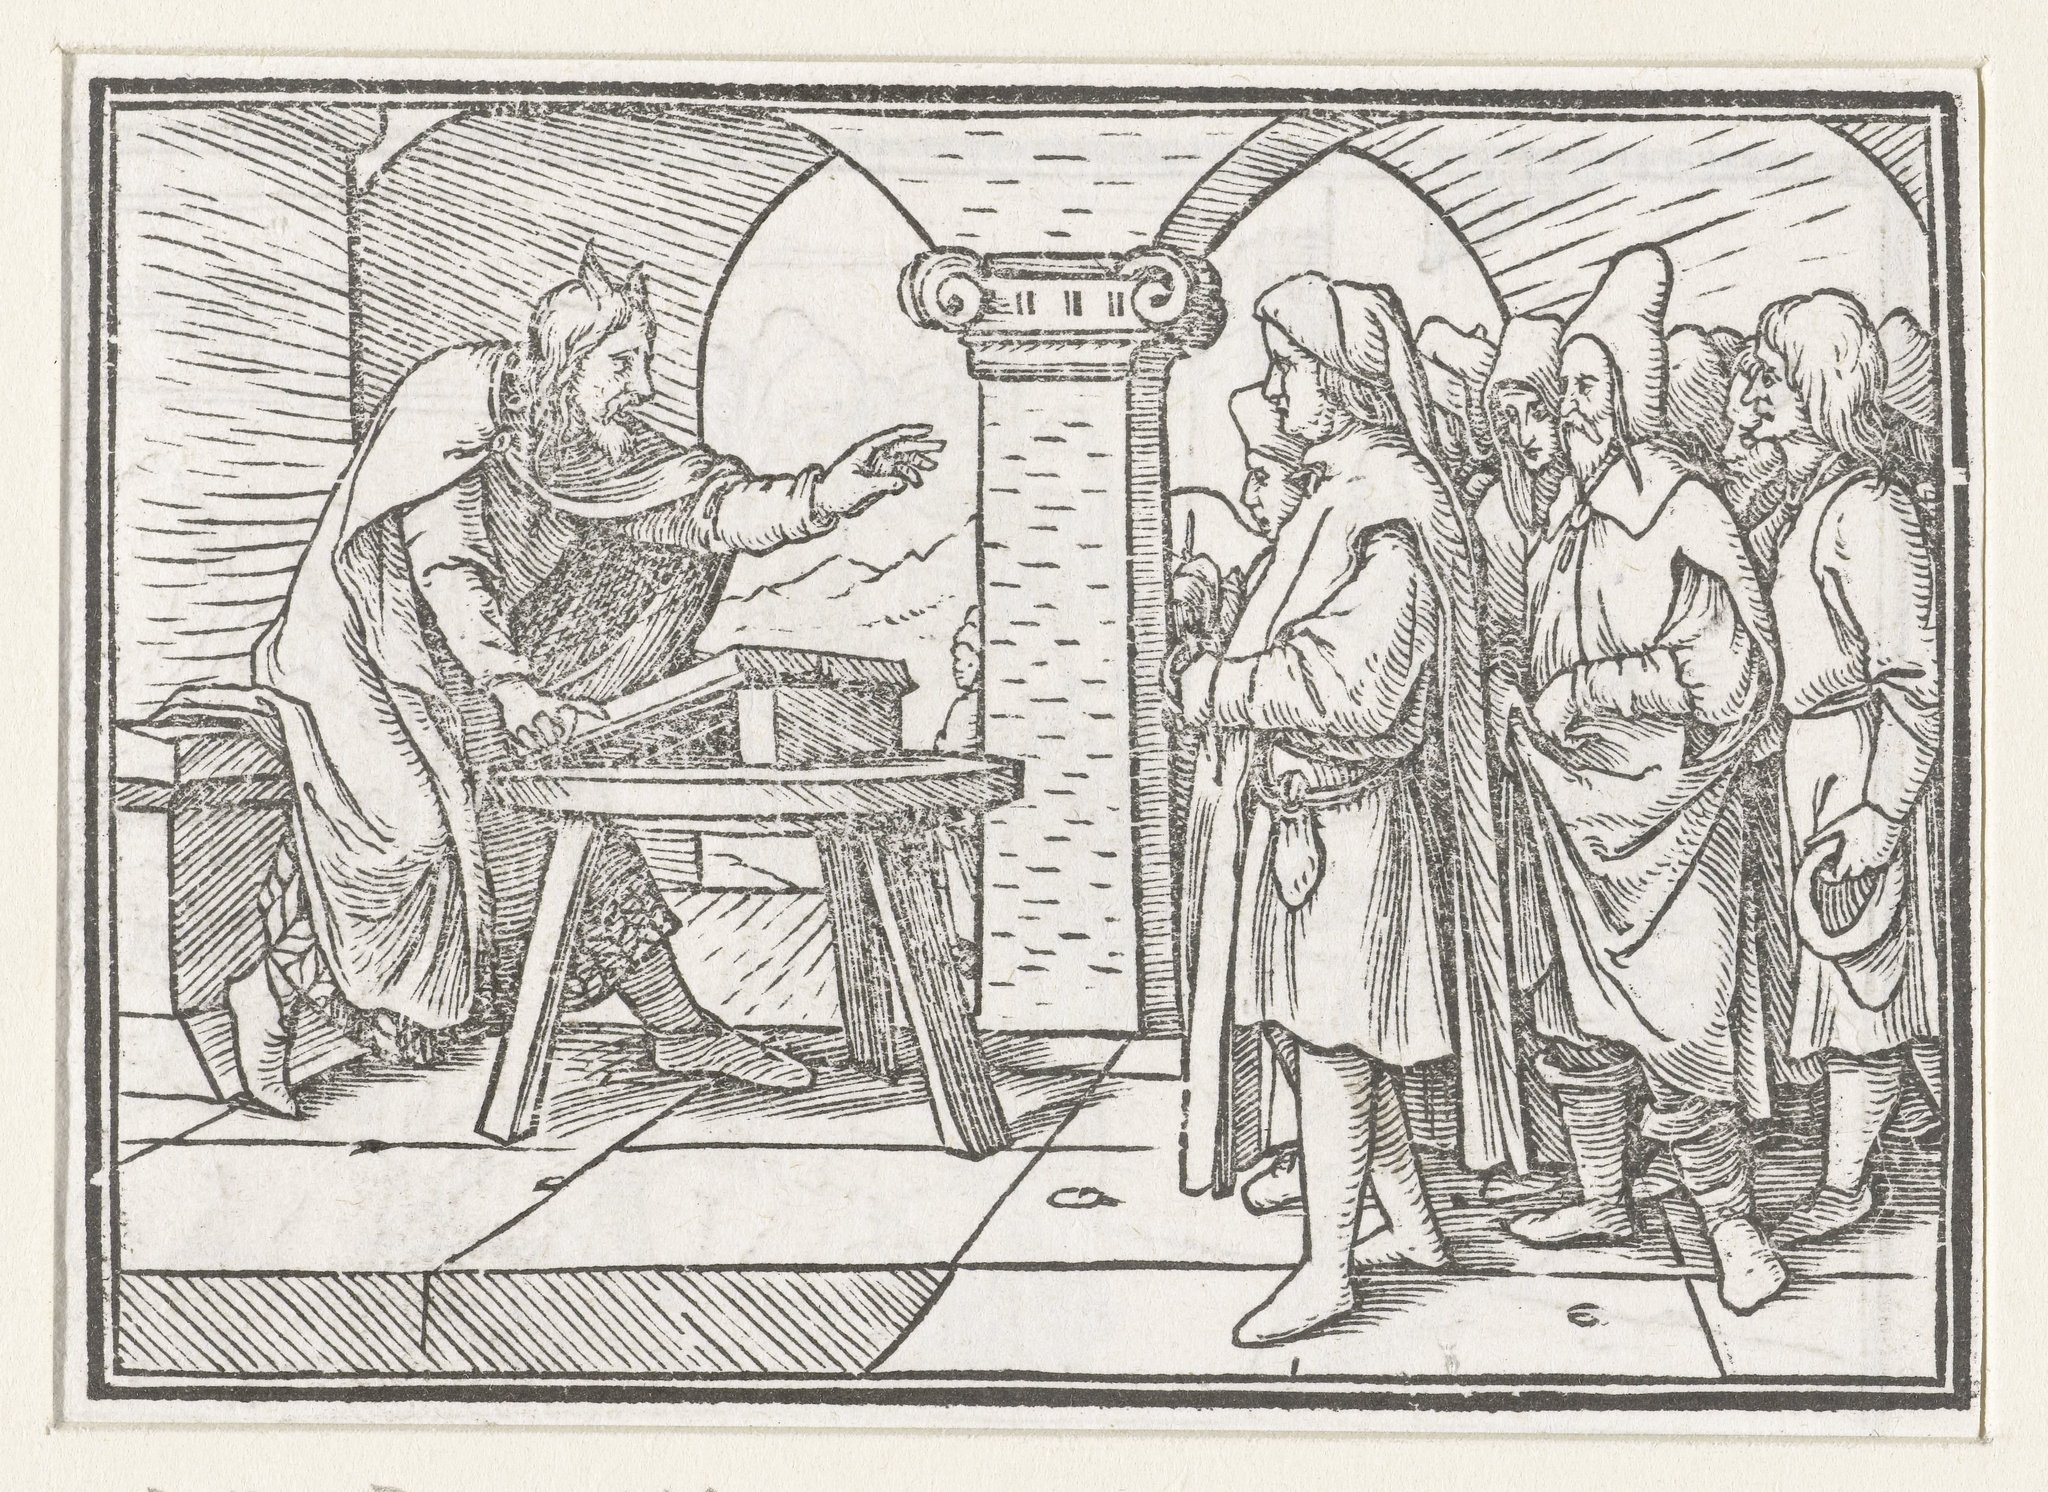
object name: print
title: Mozes onderwijst Israëlieten in wetten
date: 1538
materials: paper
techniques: woodcut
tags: moses teaching (in general)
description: Houtblok voor het eerst gebruikt in: Biblia Utriusque Testamenti iuxta Vulgatam Translationem, Lyon, M. en G. Trechsel (voor Hugo à Porta) 1538. Later in verschillende uitgaven opnieuw gebruikt.